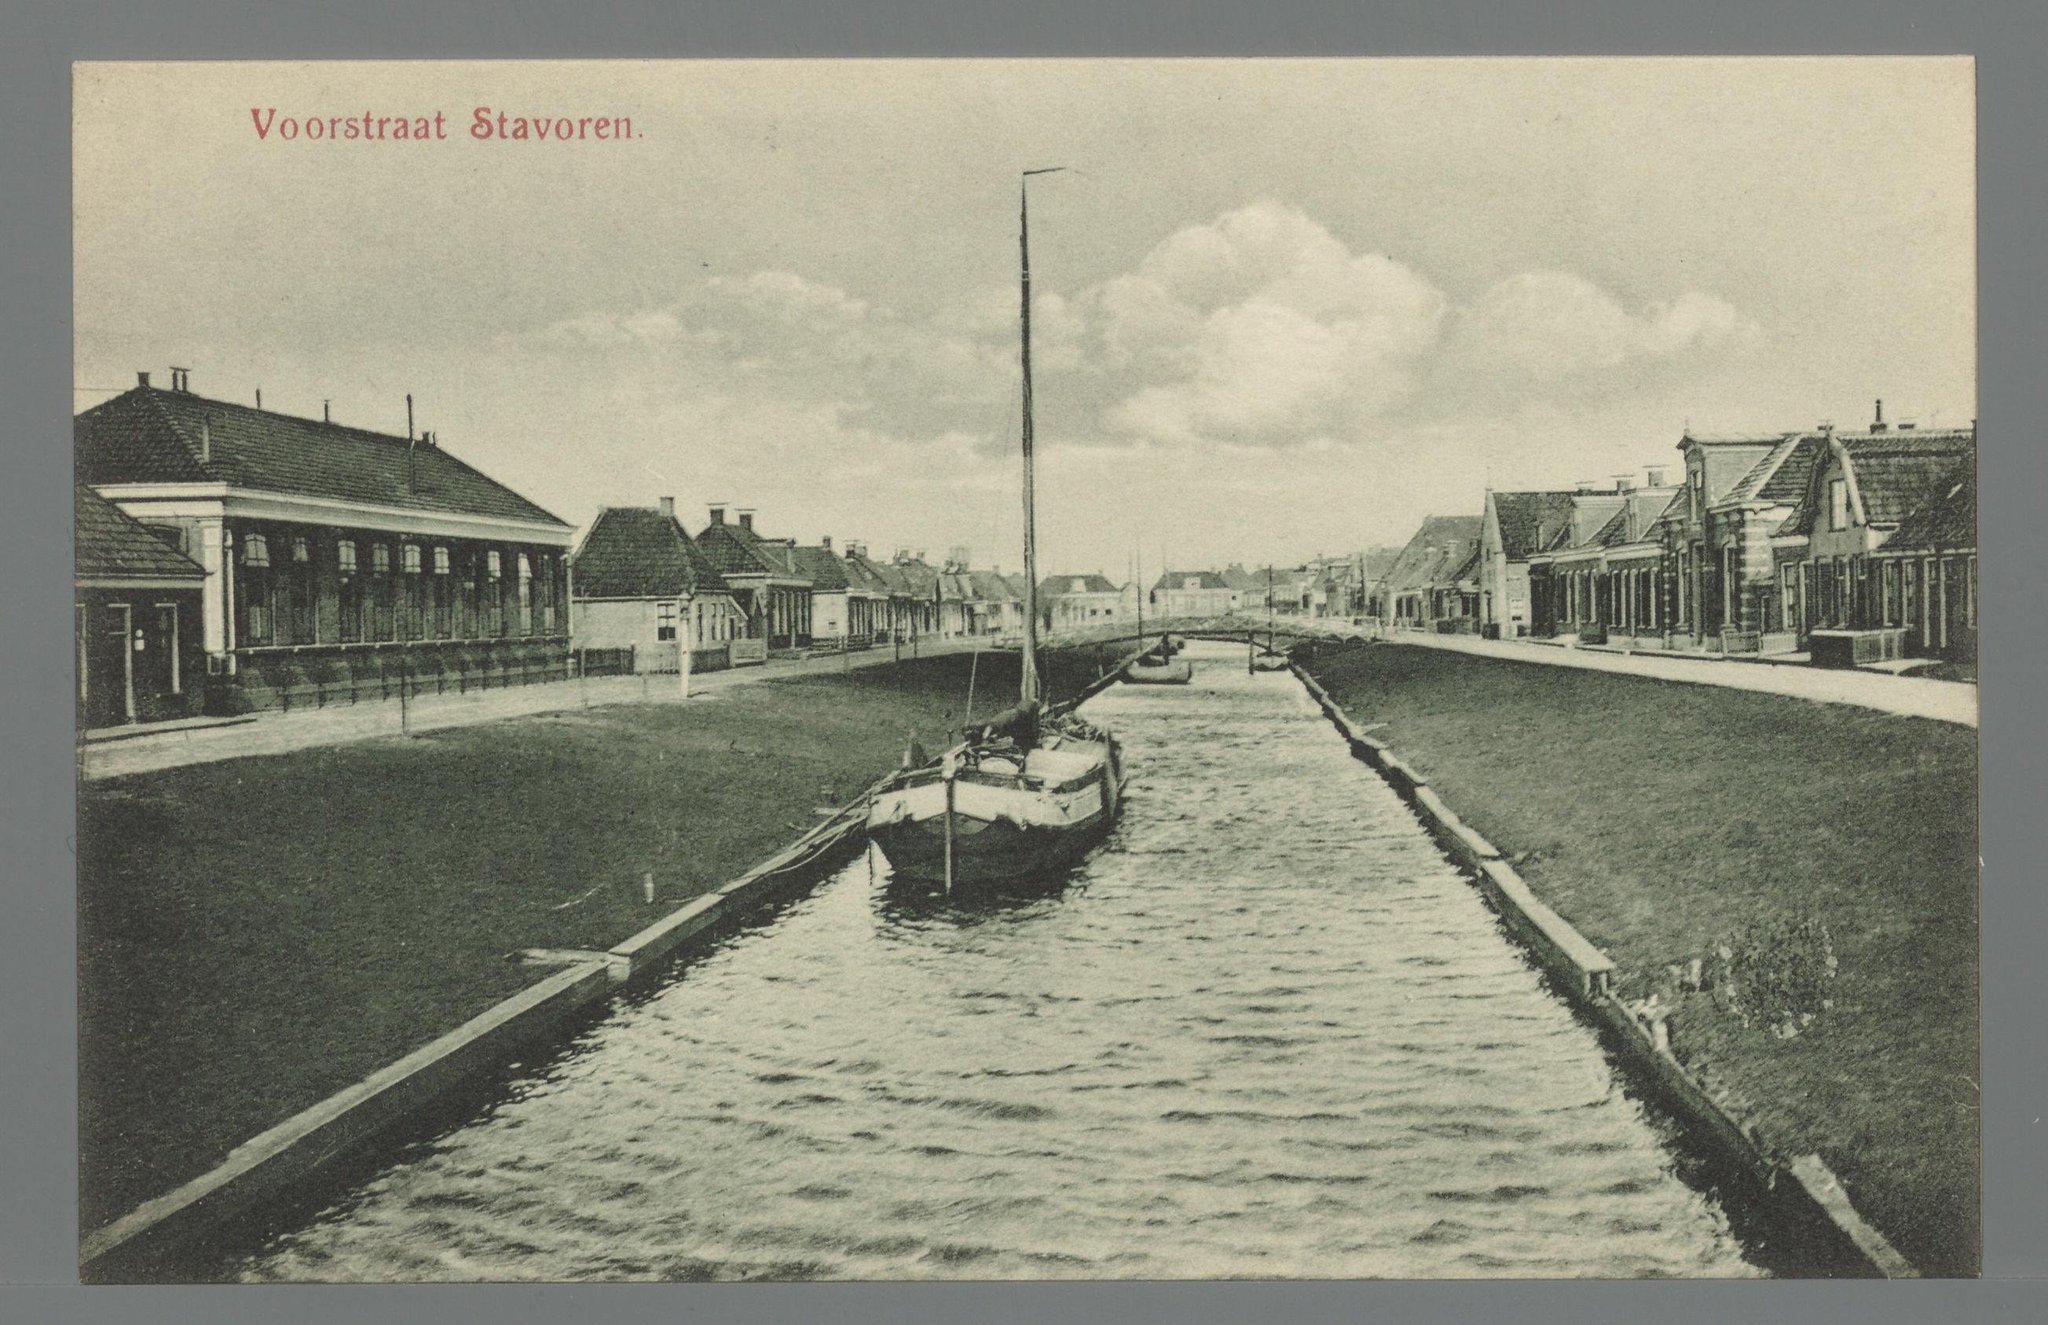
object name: ansichtkaart, prentbriefkaart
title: Voorstraat Stavoren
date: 1905-1930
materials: cardboard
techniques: photograph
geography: stavoren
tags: sailing-ship, sailing-boat, canal, street